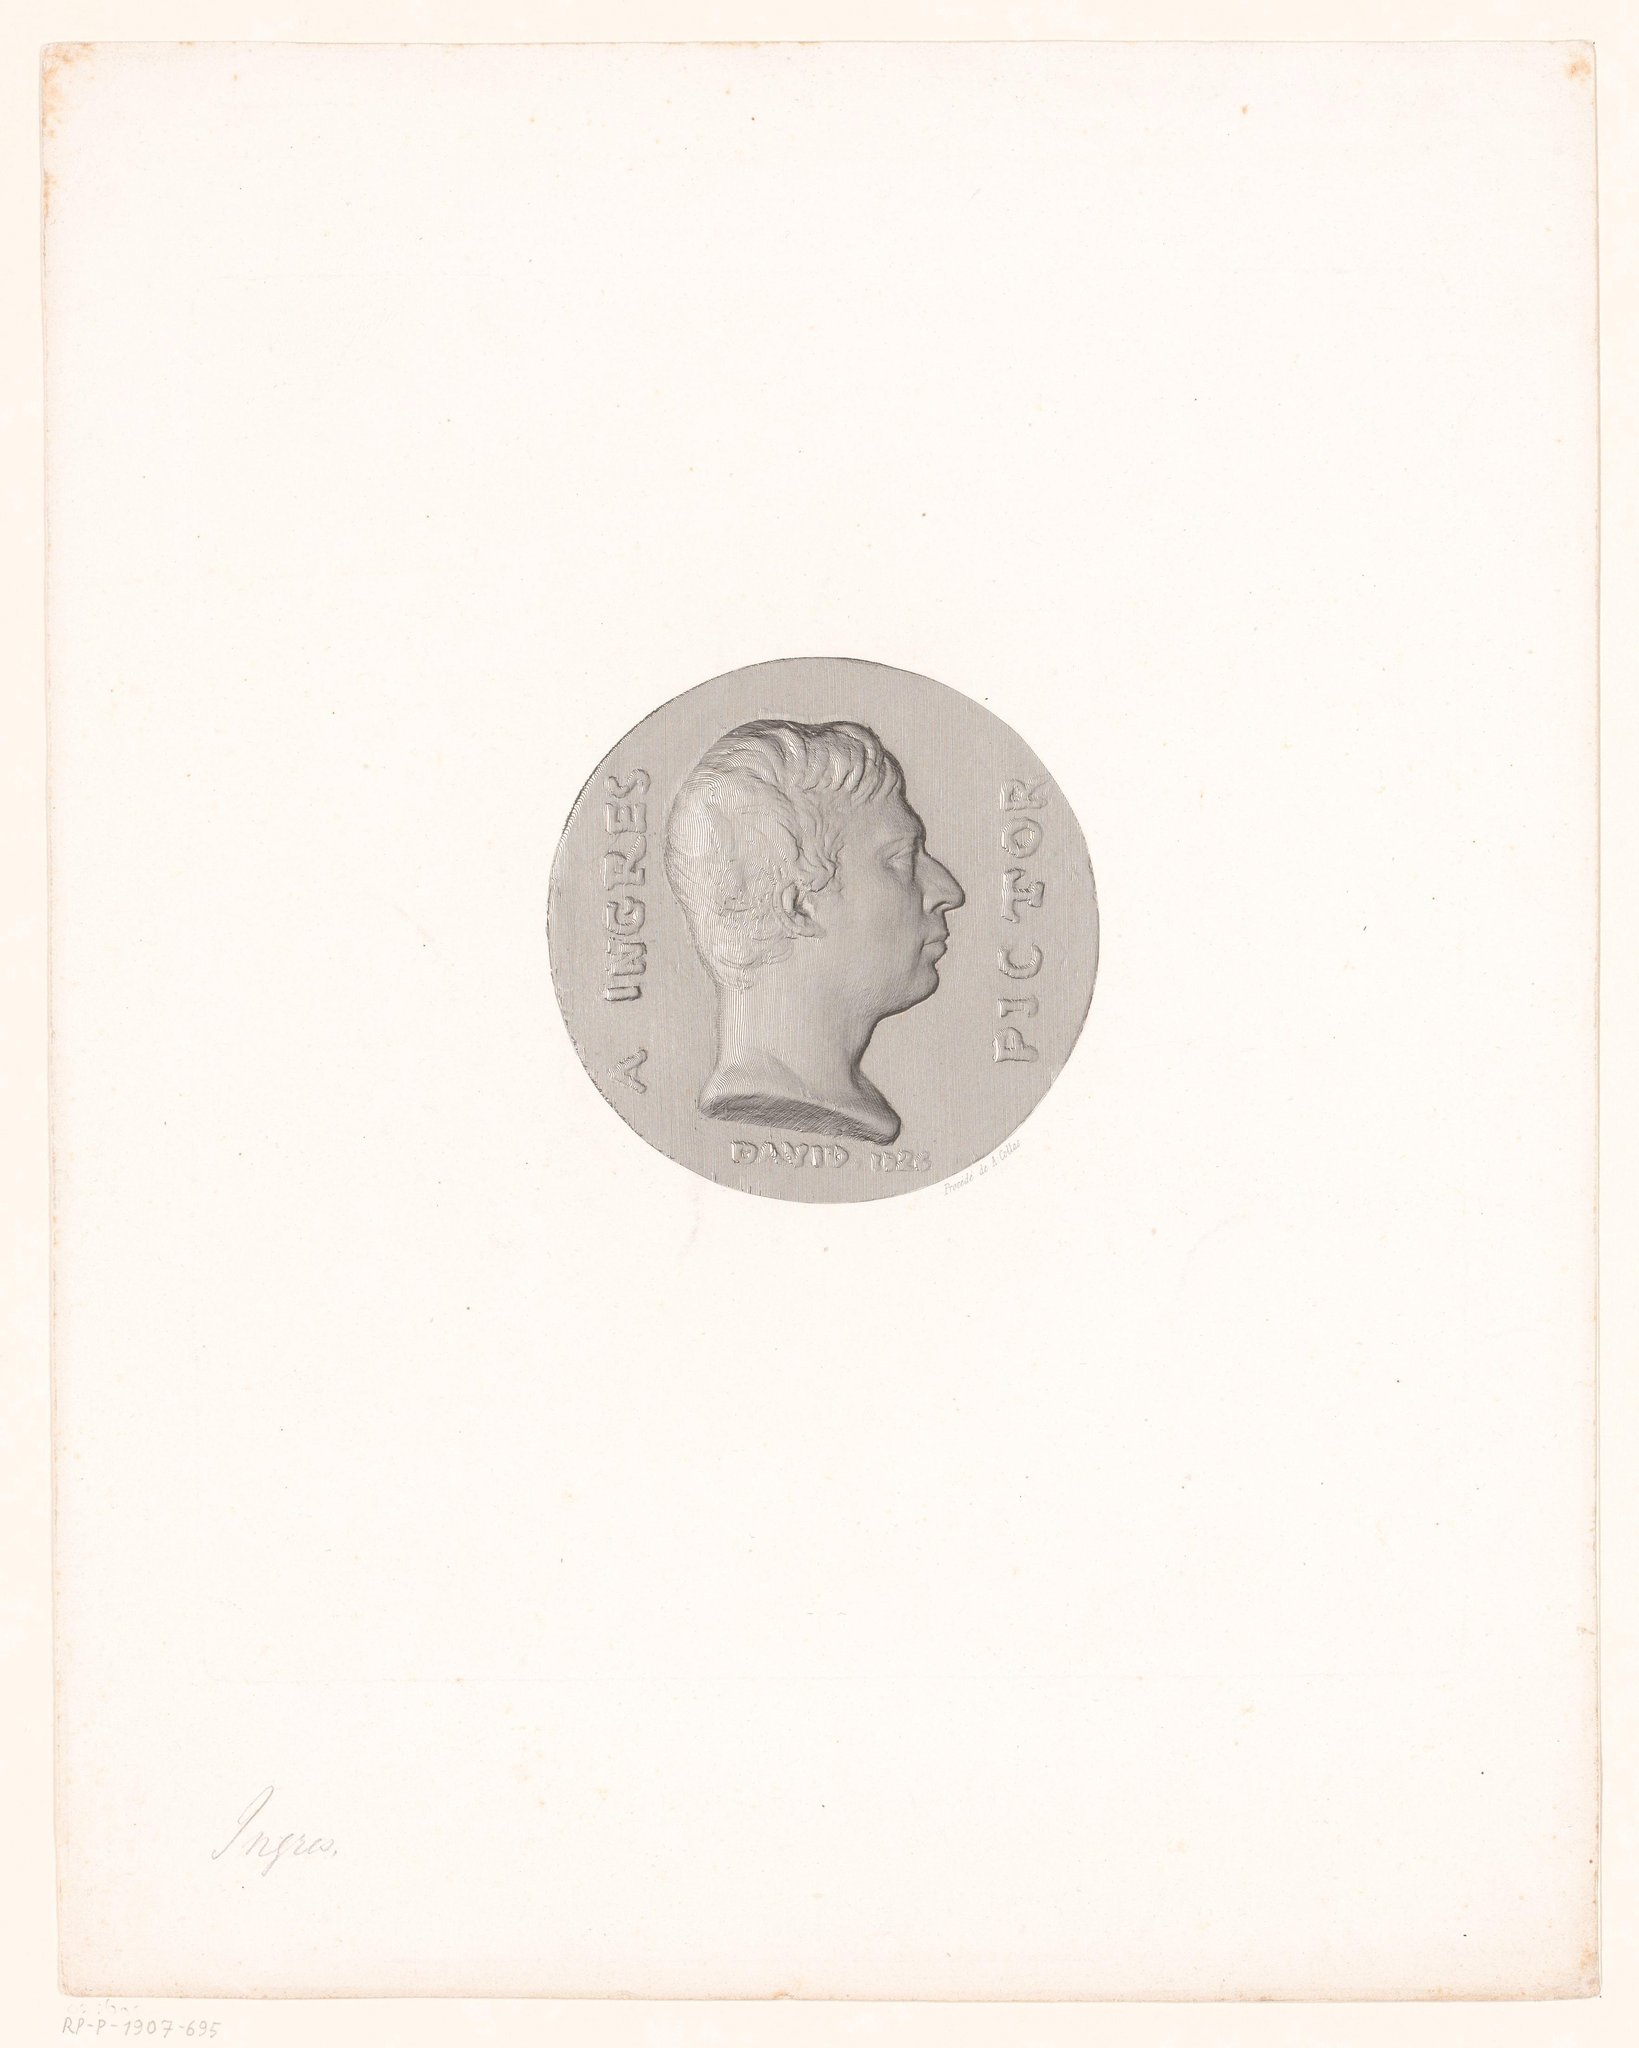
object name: print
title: A Ingres pictor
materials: paper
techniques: relief engraving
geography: france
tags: paris, print maker, draughtsman, jean auguste dominique ingres, ornament ~ medallion, portrait, self-portrait of painter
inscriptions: collector's mark: Lugt 2228